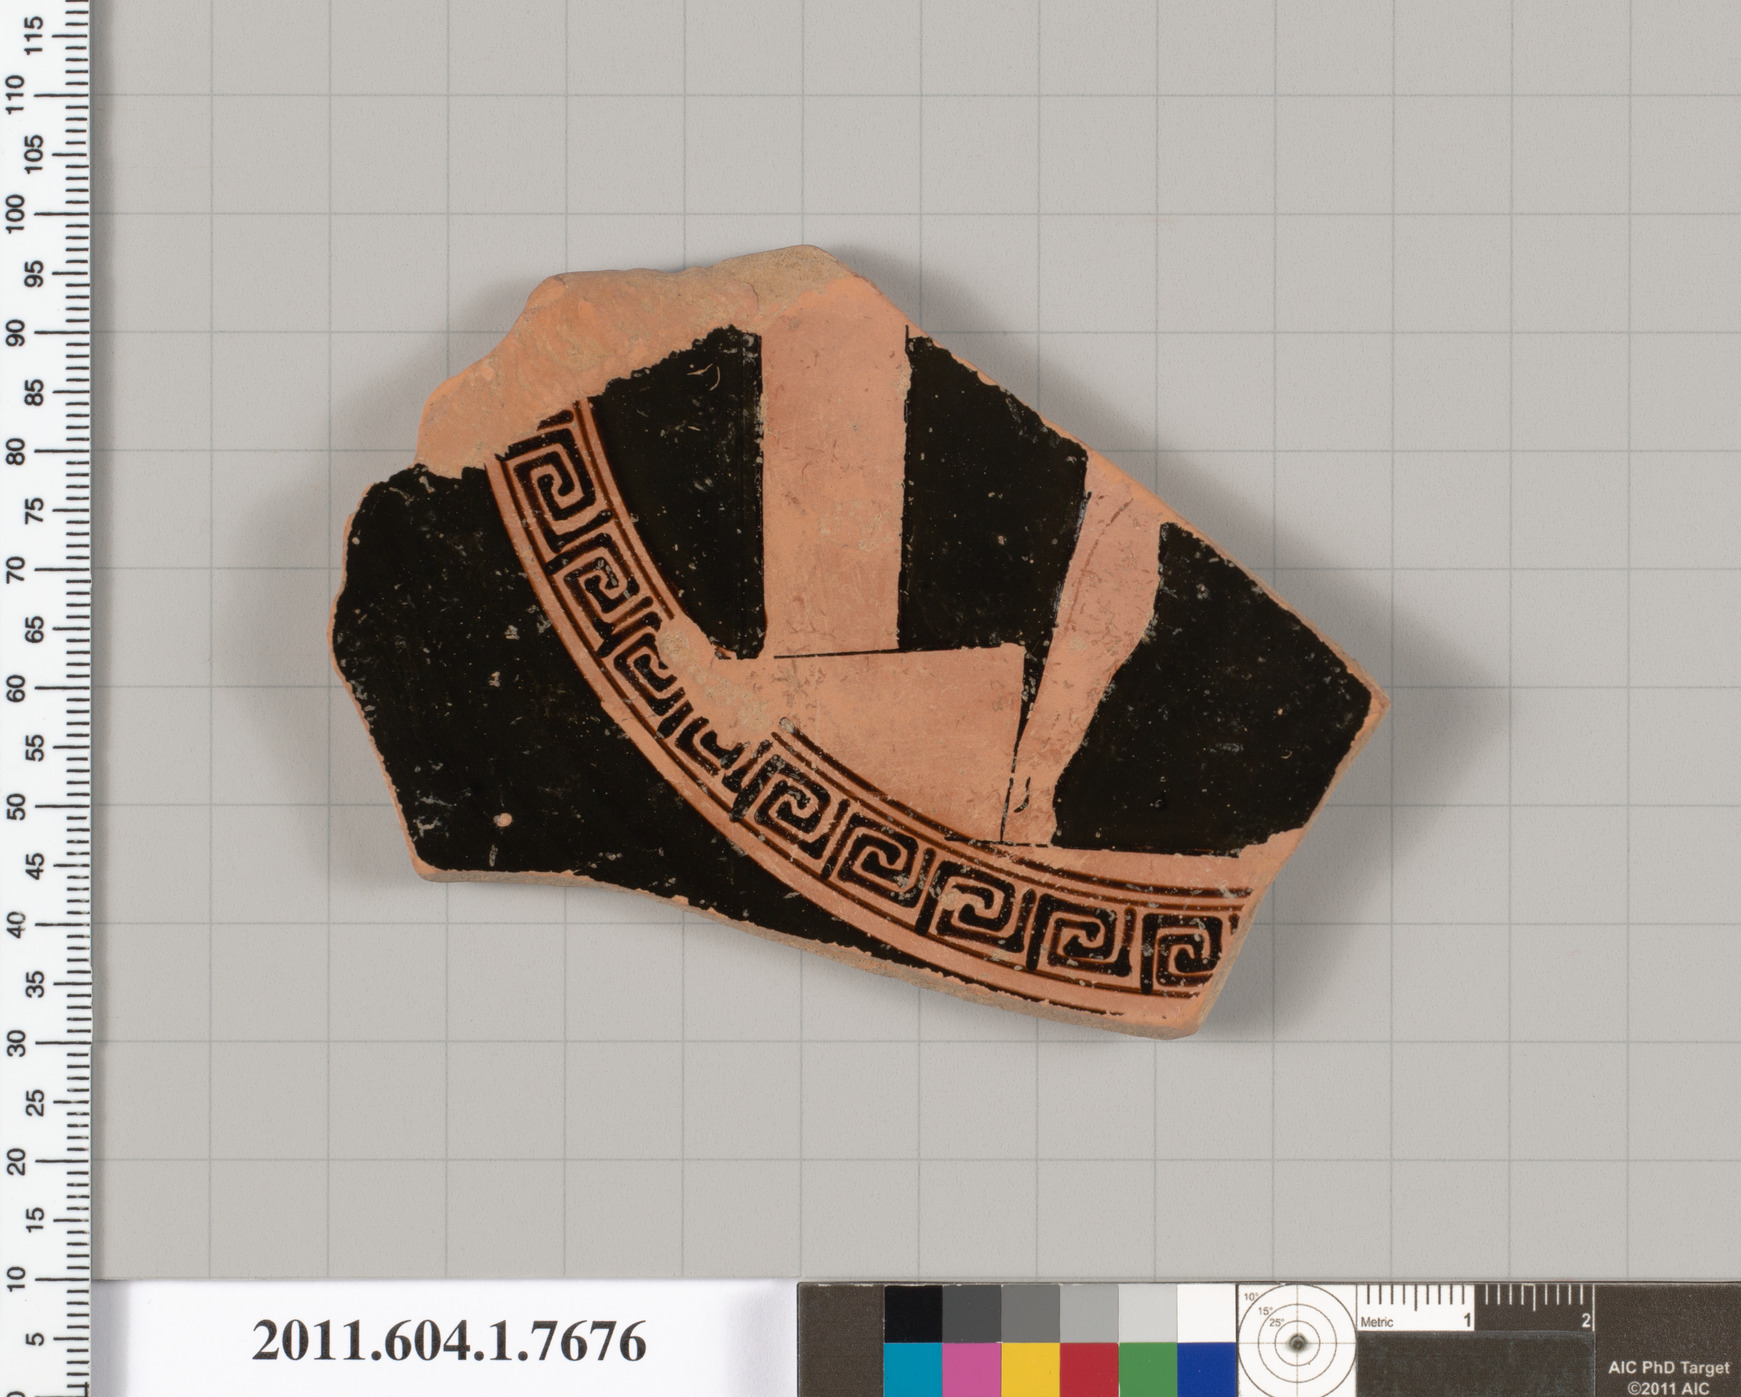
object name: kylix fragment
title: Terracotta fragment of a kylix (drinking cup)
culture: greek, attic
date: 475-451 BCE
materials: terracotta